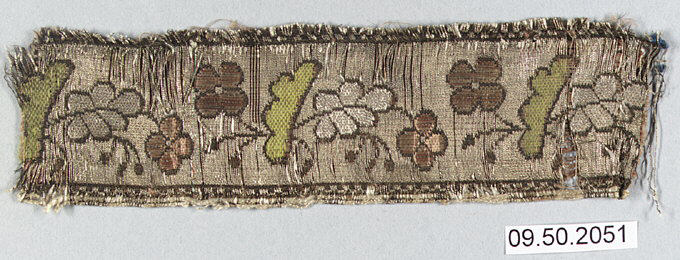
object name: band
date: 1701-1800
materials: linen, metal thread, silk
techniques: brocade, weave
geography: poland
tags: flowers